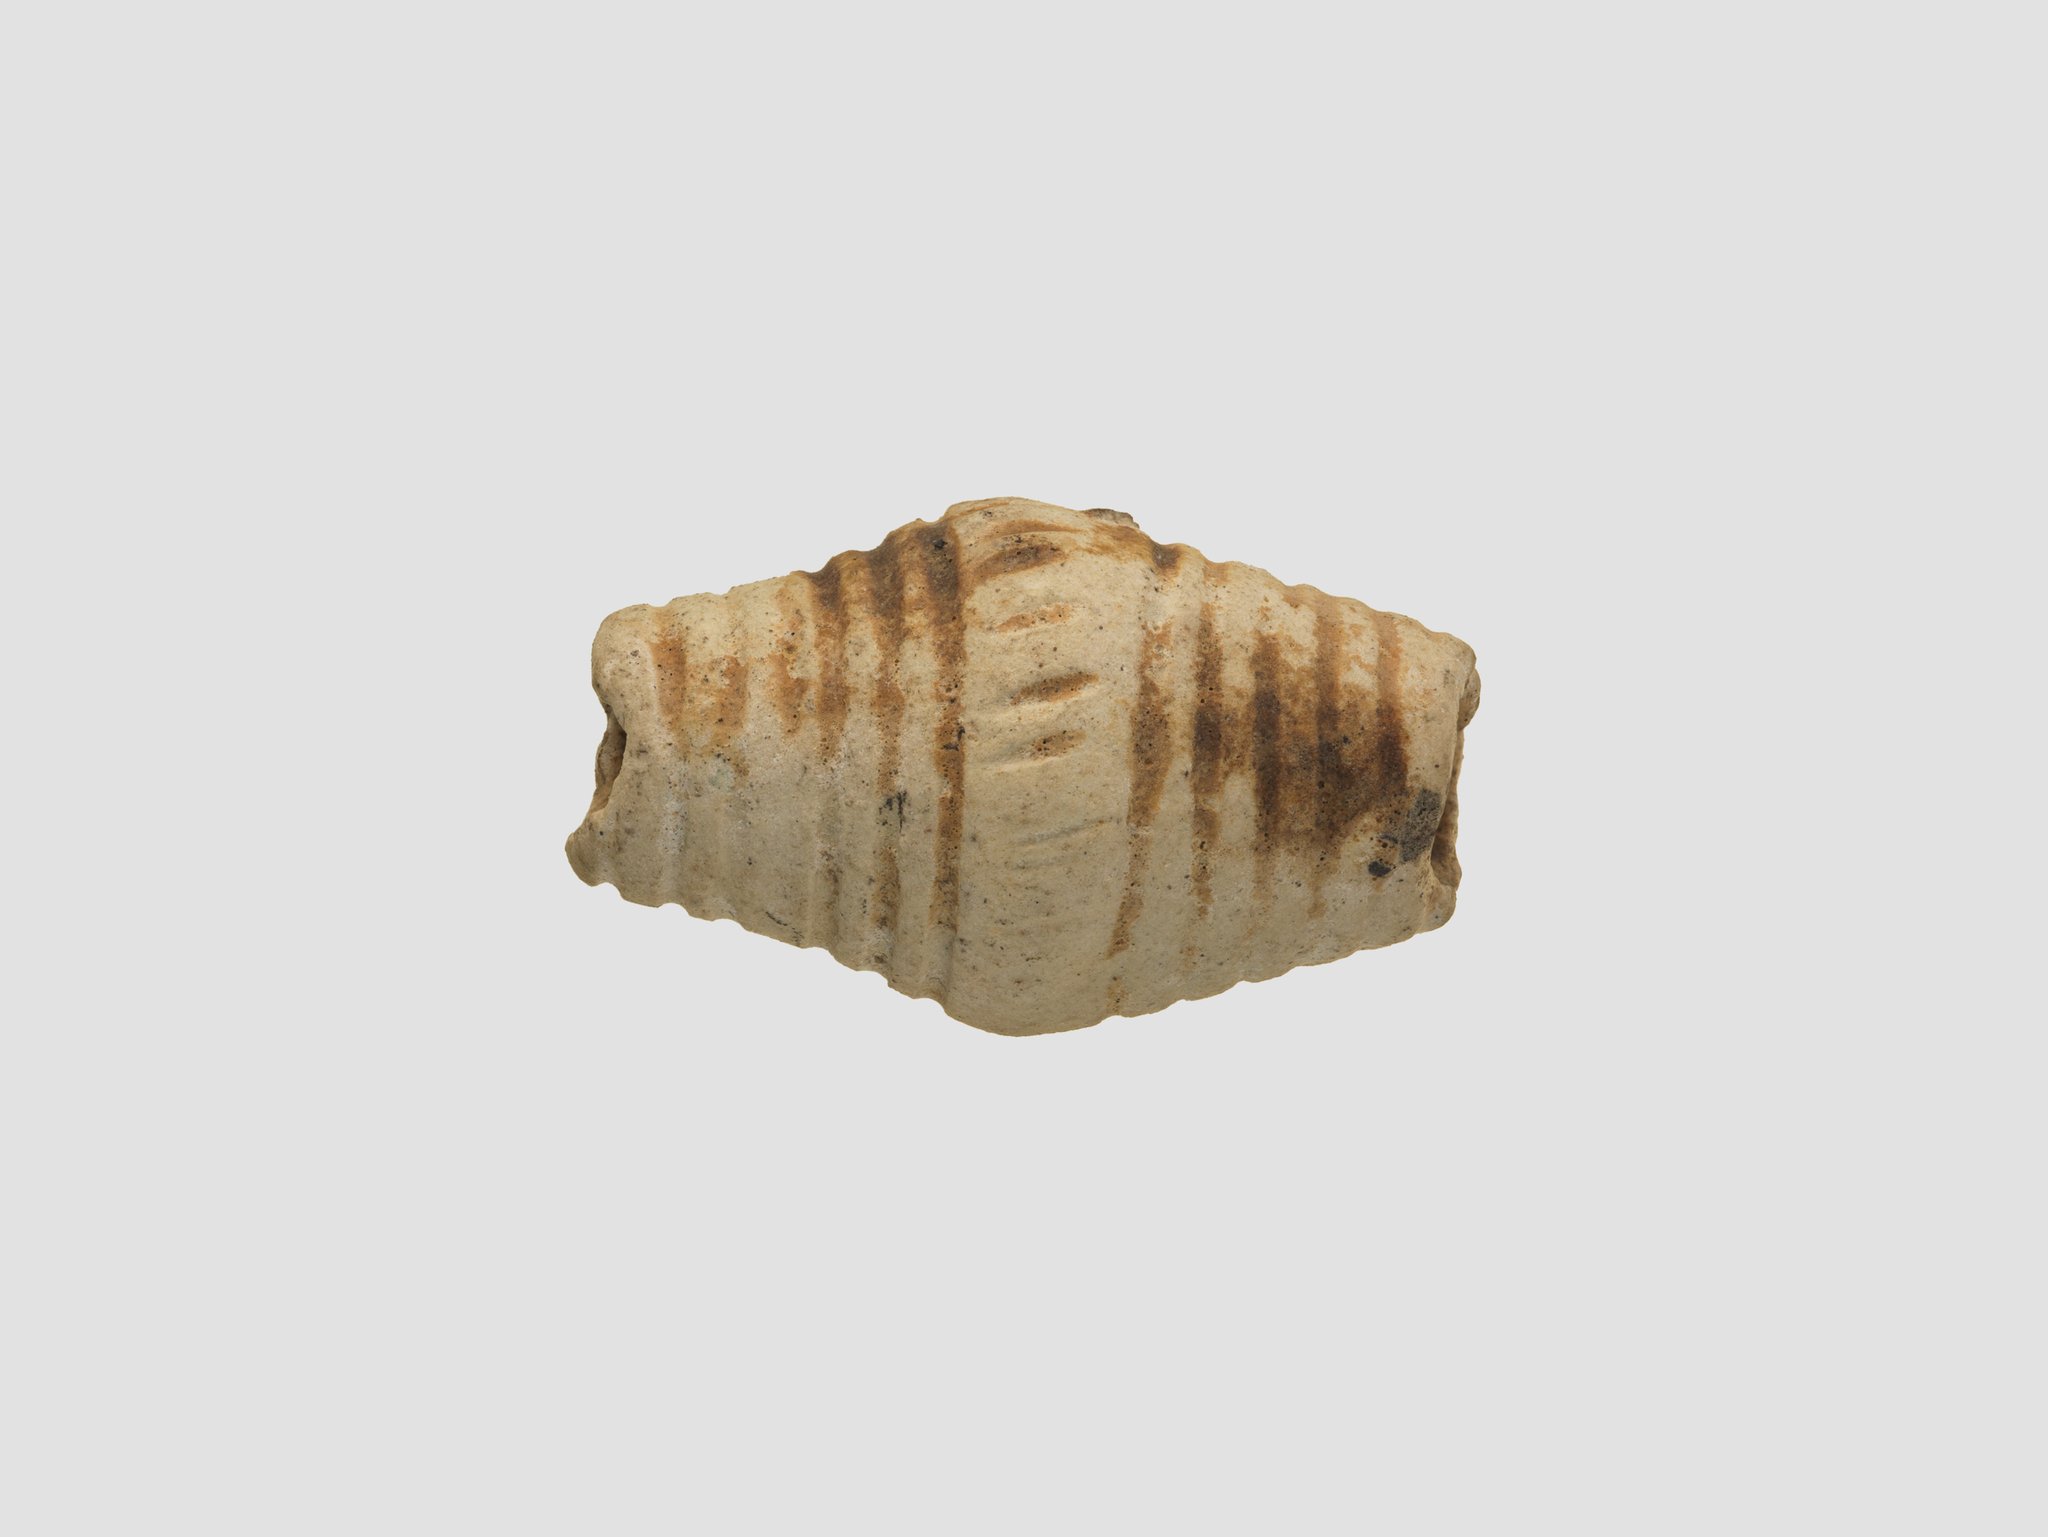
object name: bead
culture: iranian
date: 900-801 BCE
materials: faience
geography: iran